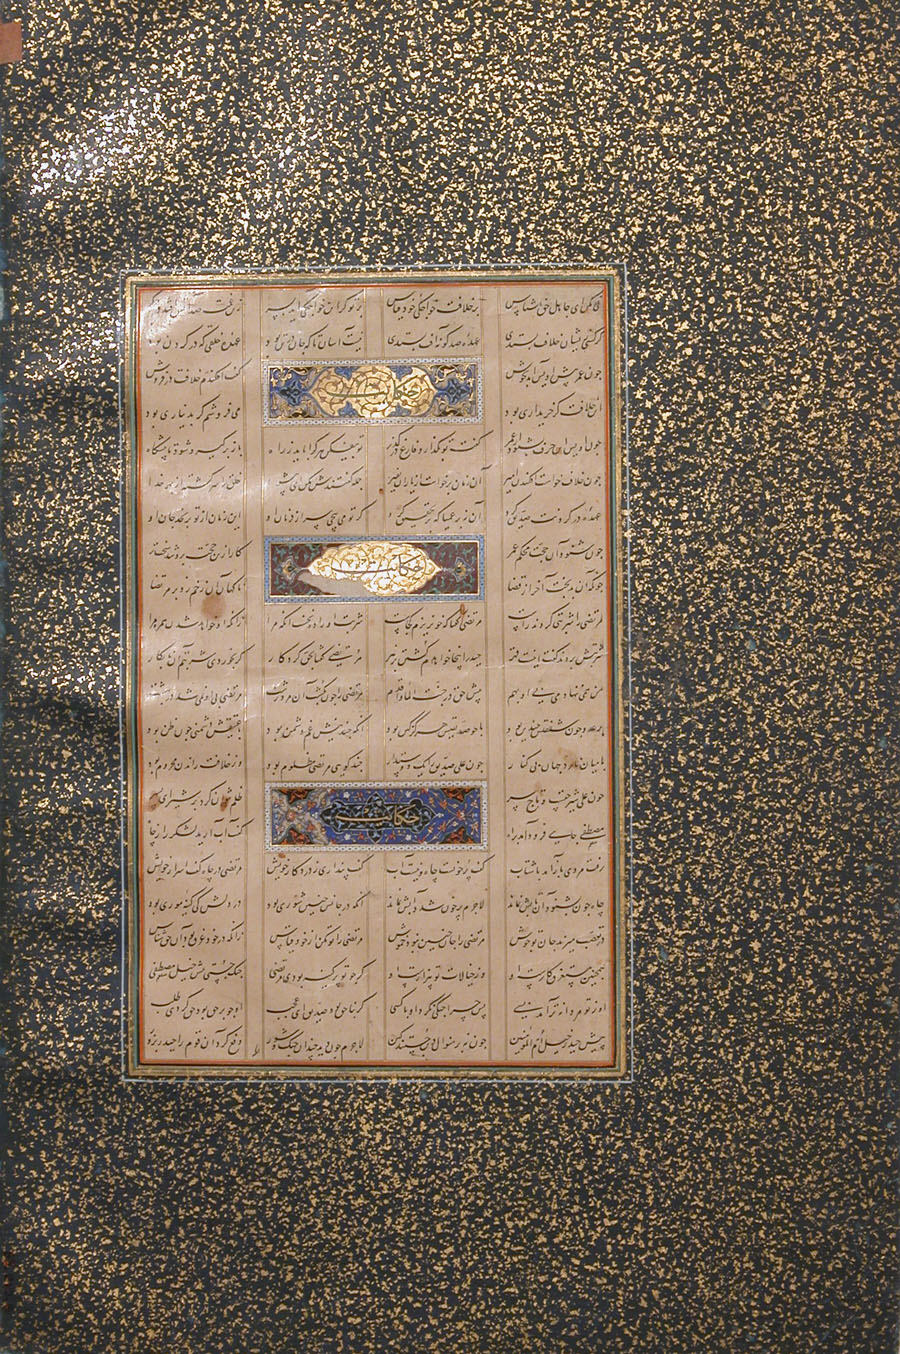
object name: folio from an illustrated manuscript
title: Folio from a Mantiq al-Tayr (Language of the Birds)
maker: farid al-din `attar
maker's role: author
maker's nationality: iranian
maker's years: 1142-1220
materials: gold, ink, paper, silver, watercolor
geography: iran